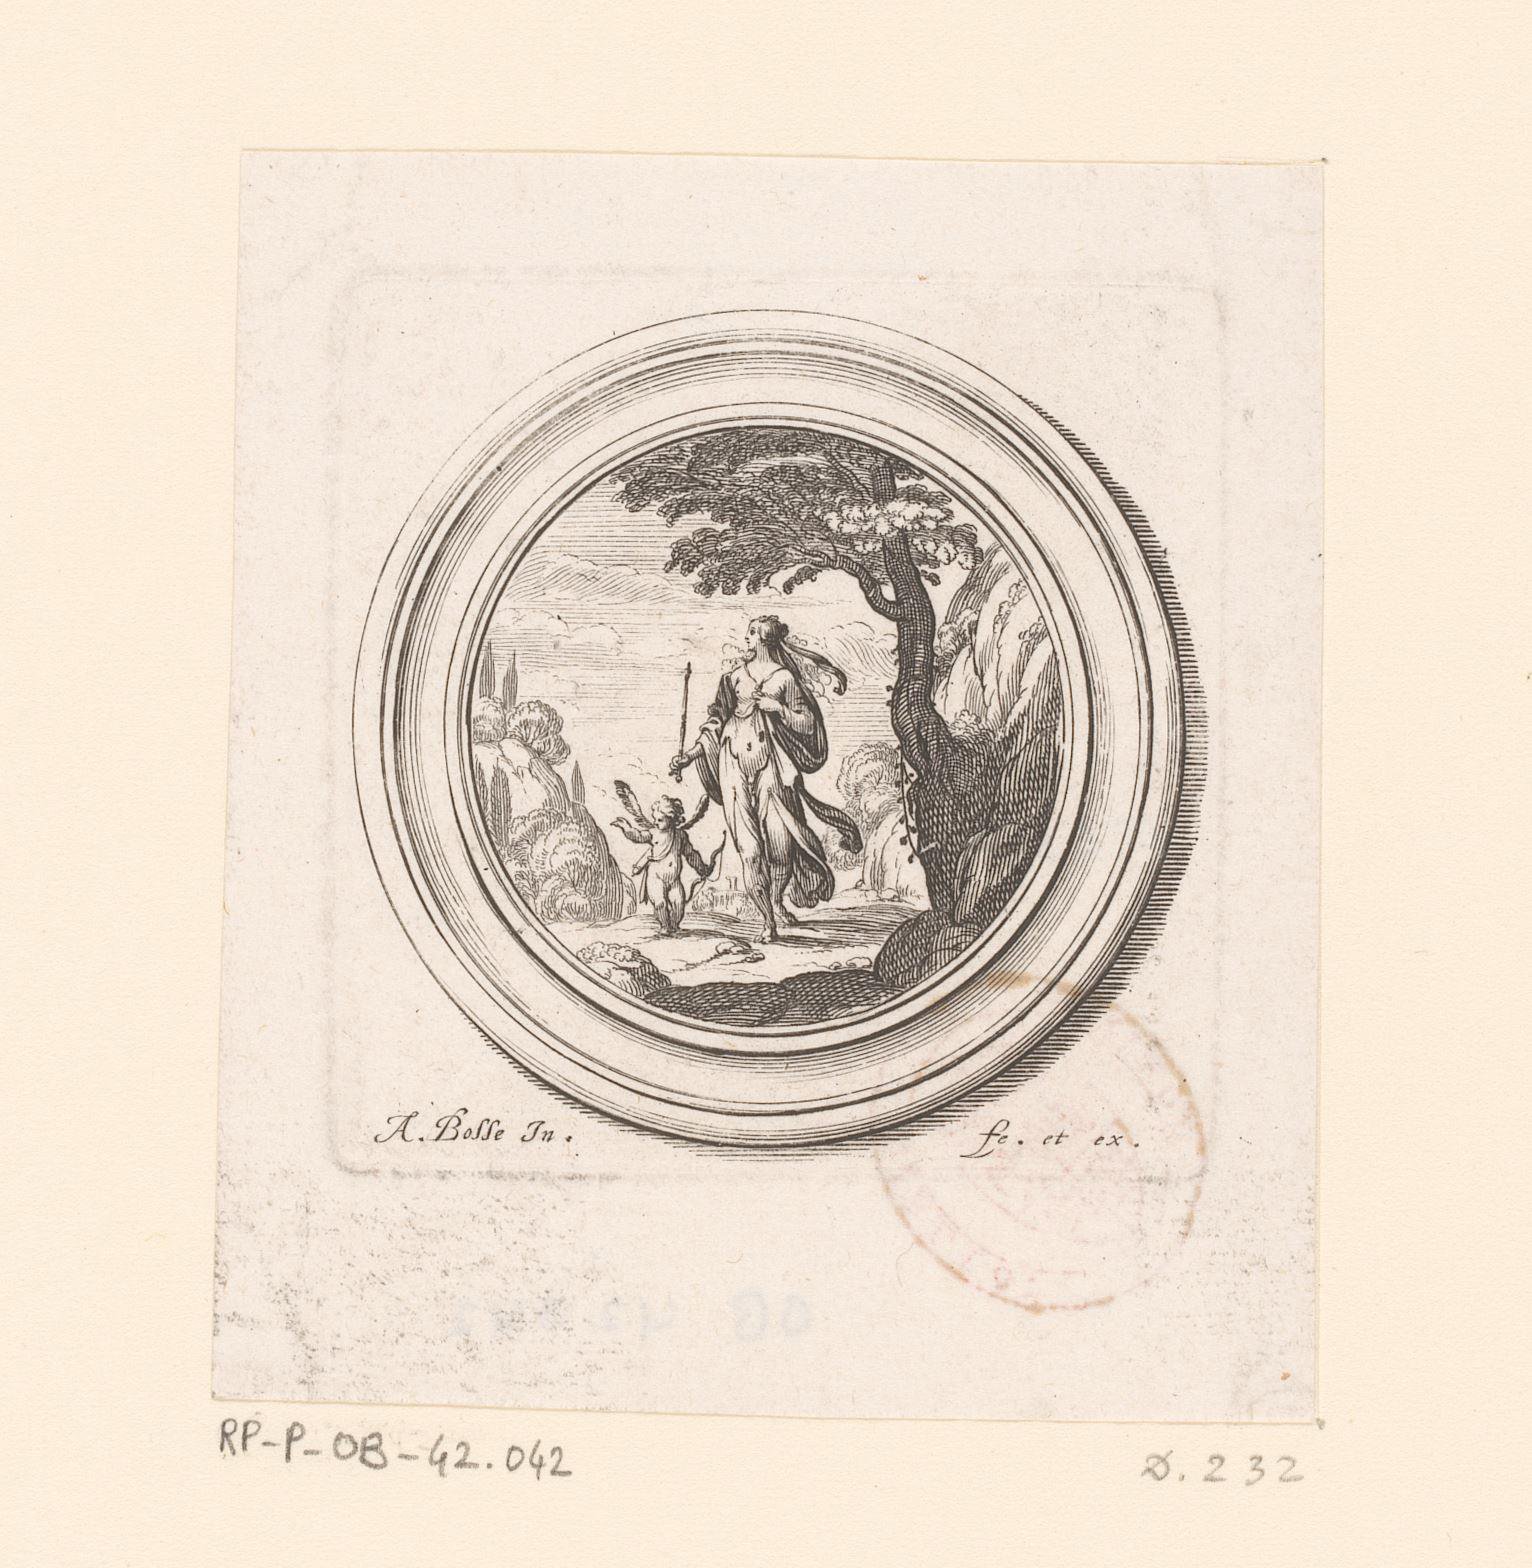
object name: print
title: Venus en Amor in een landschap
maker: abraham bosse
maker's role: draughtsman, print maker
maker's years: 1602-1676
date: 1612-1676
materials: paper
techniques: engraving, etching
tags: (story of) cupid, amor (eros), (story of) venus (aphrodite), venus and cupid (cupid not being mere attribute)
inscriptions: collector's mark: Lugt 240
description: Maakt deel uit van een serie van drie prenten met de godinnen Juno, Venus en Minerva in ronde omlijstingen. De serie werd ontworpen, vervaardigd en uitgegeven door Abraham Bosse.